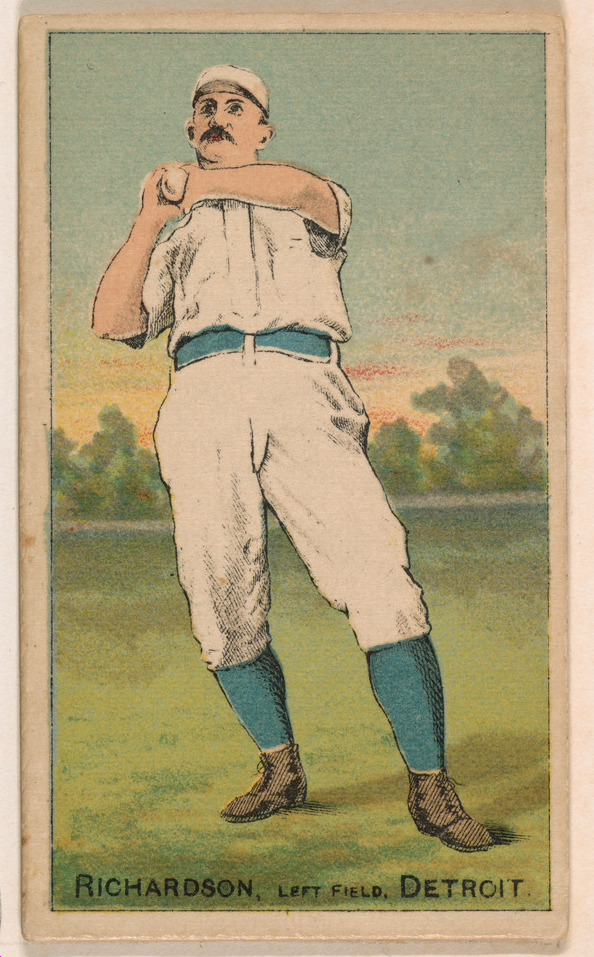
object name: baseball card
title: Richardson (Hands At Right Shoulder), Left Field, Detroit, from the Gold Coin series (N284) for Gold Coin Chewing Tobacco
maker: d. buchner & co., new york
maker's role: publisher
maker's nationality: american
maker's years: 1850-1900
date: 1887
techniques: color lithograph, drawing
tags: men,baseball,athletes